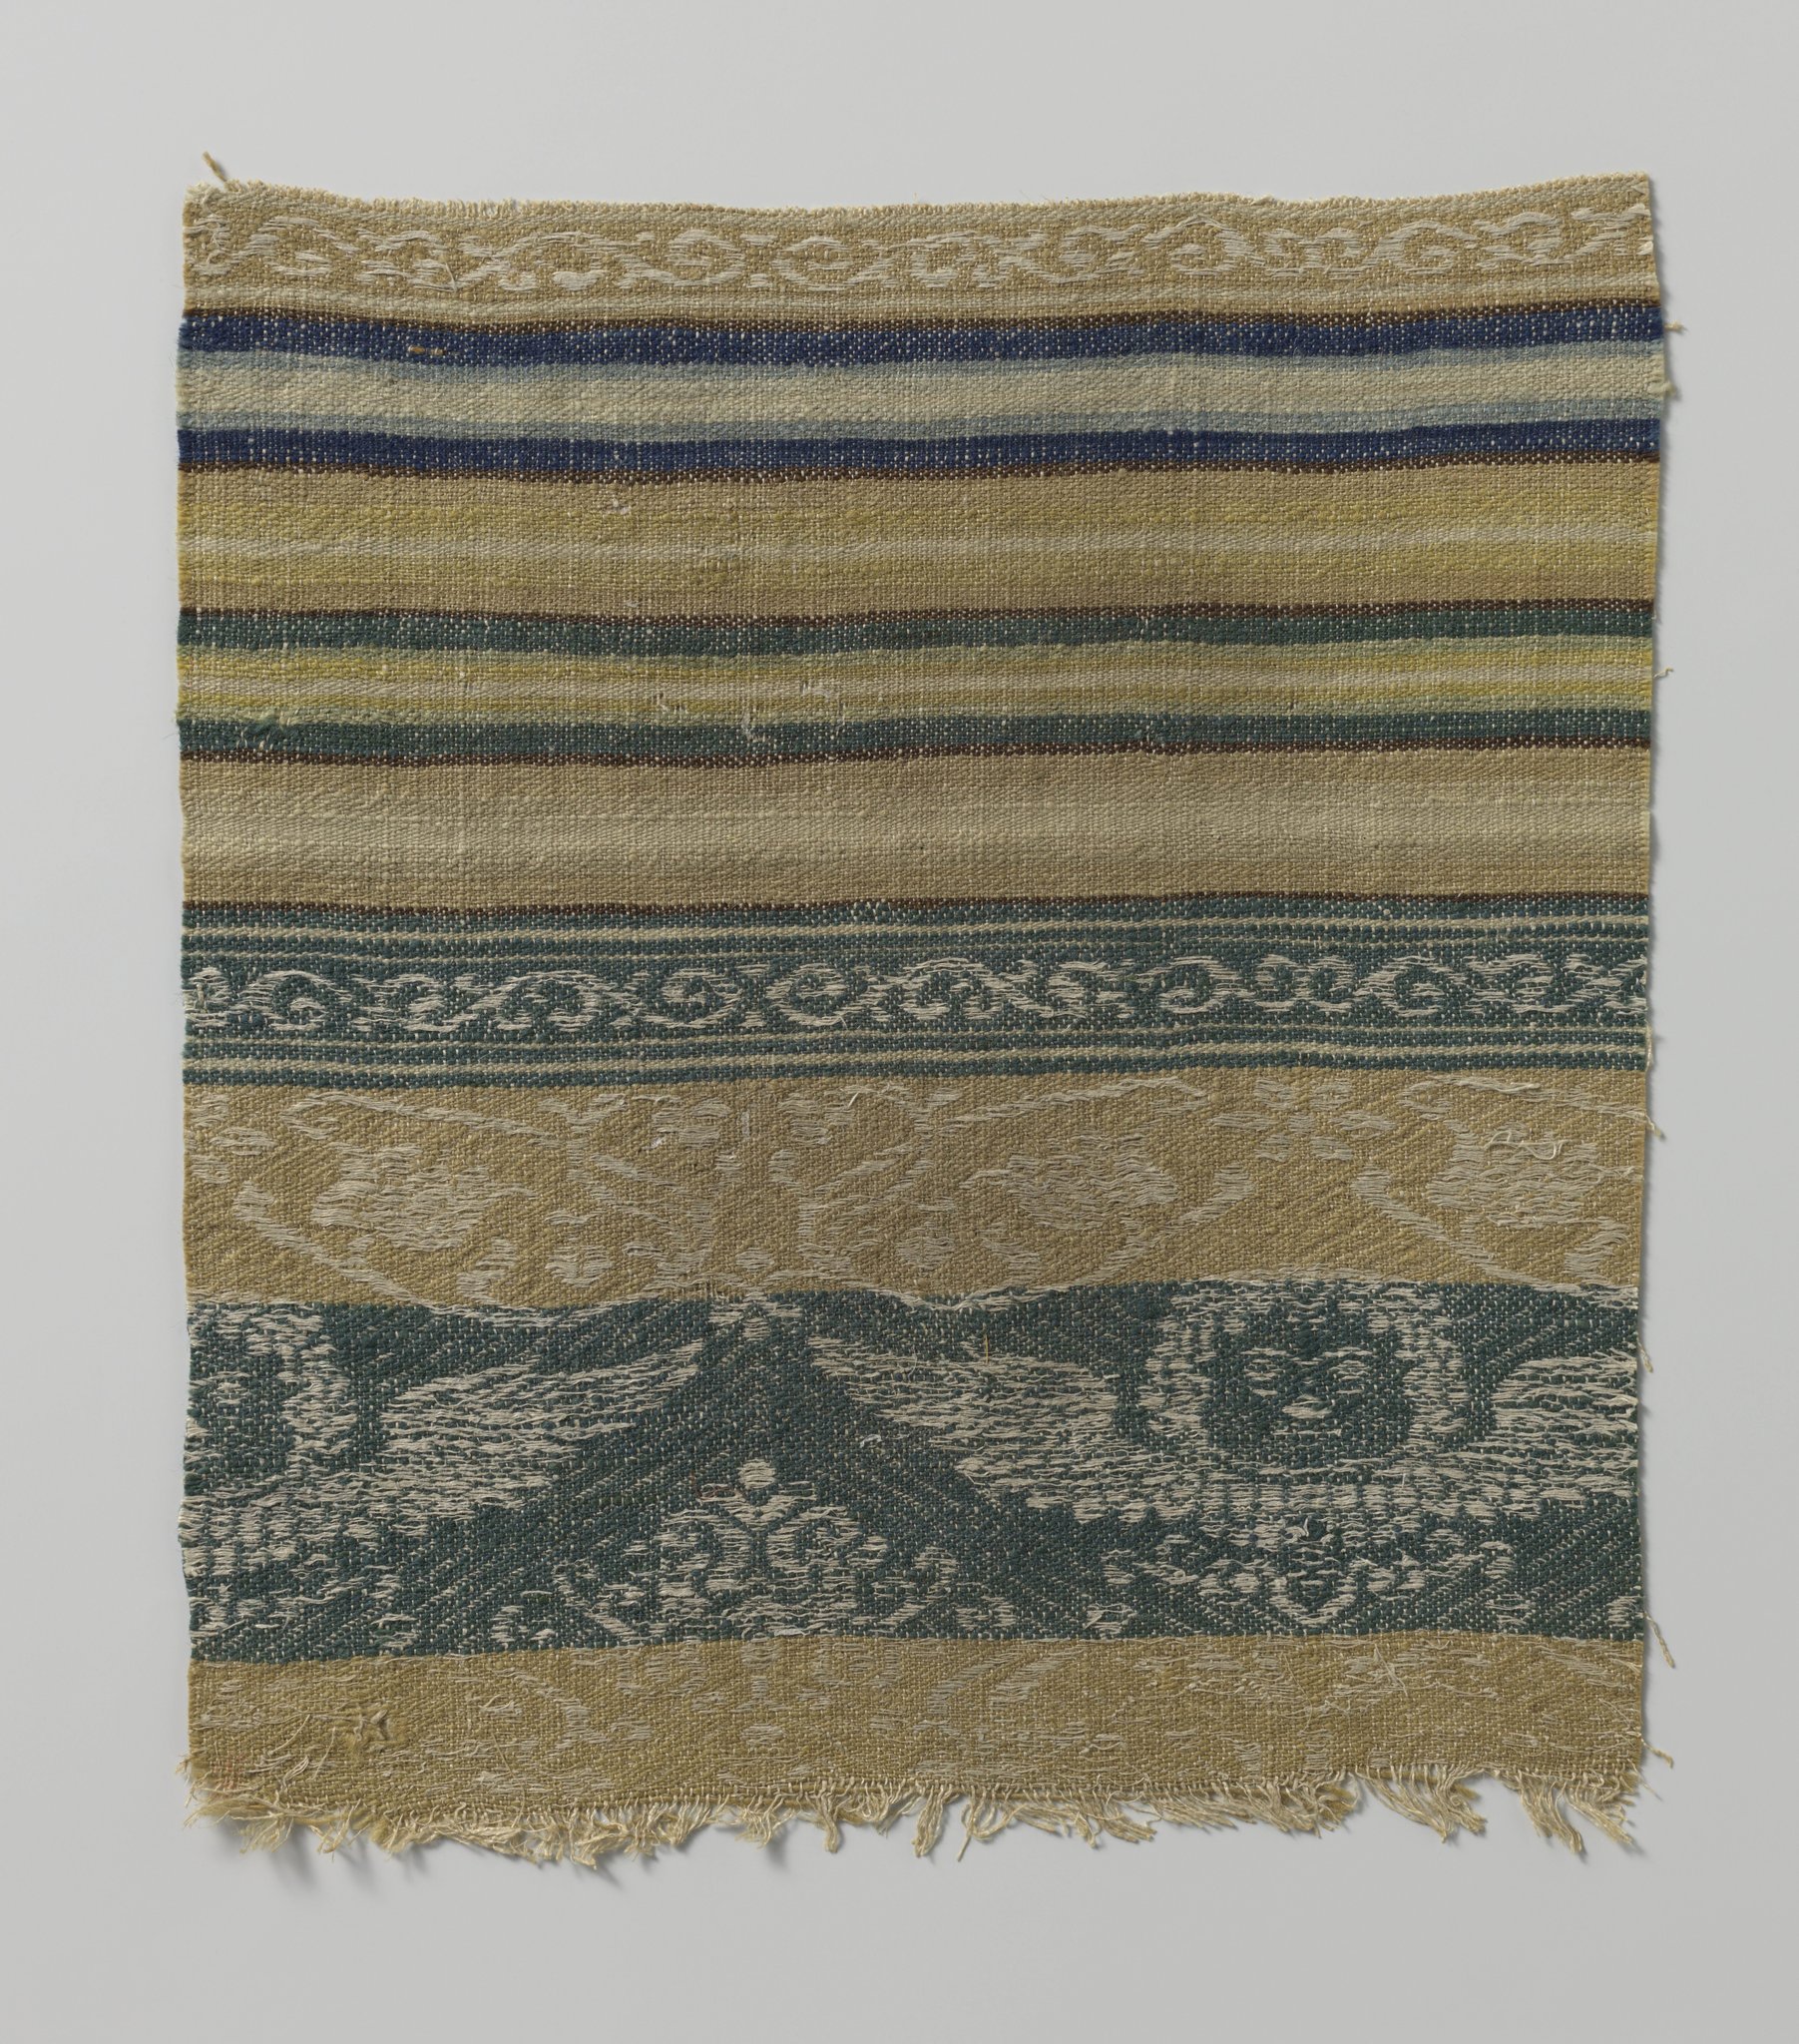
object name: woven material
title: Fragment geweven weefsel in linnen en wol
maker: Anonymous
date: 1580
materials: linen, wool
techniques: weave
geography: germany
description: Fragment gestreepte stof met o.a. decoratie van cherubs.